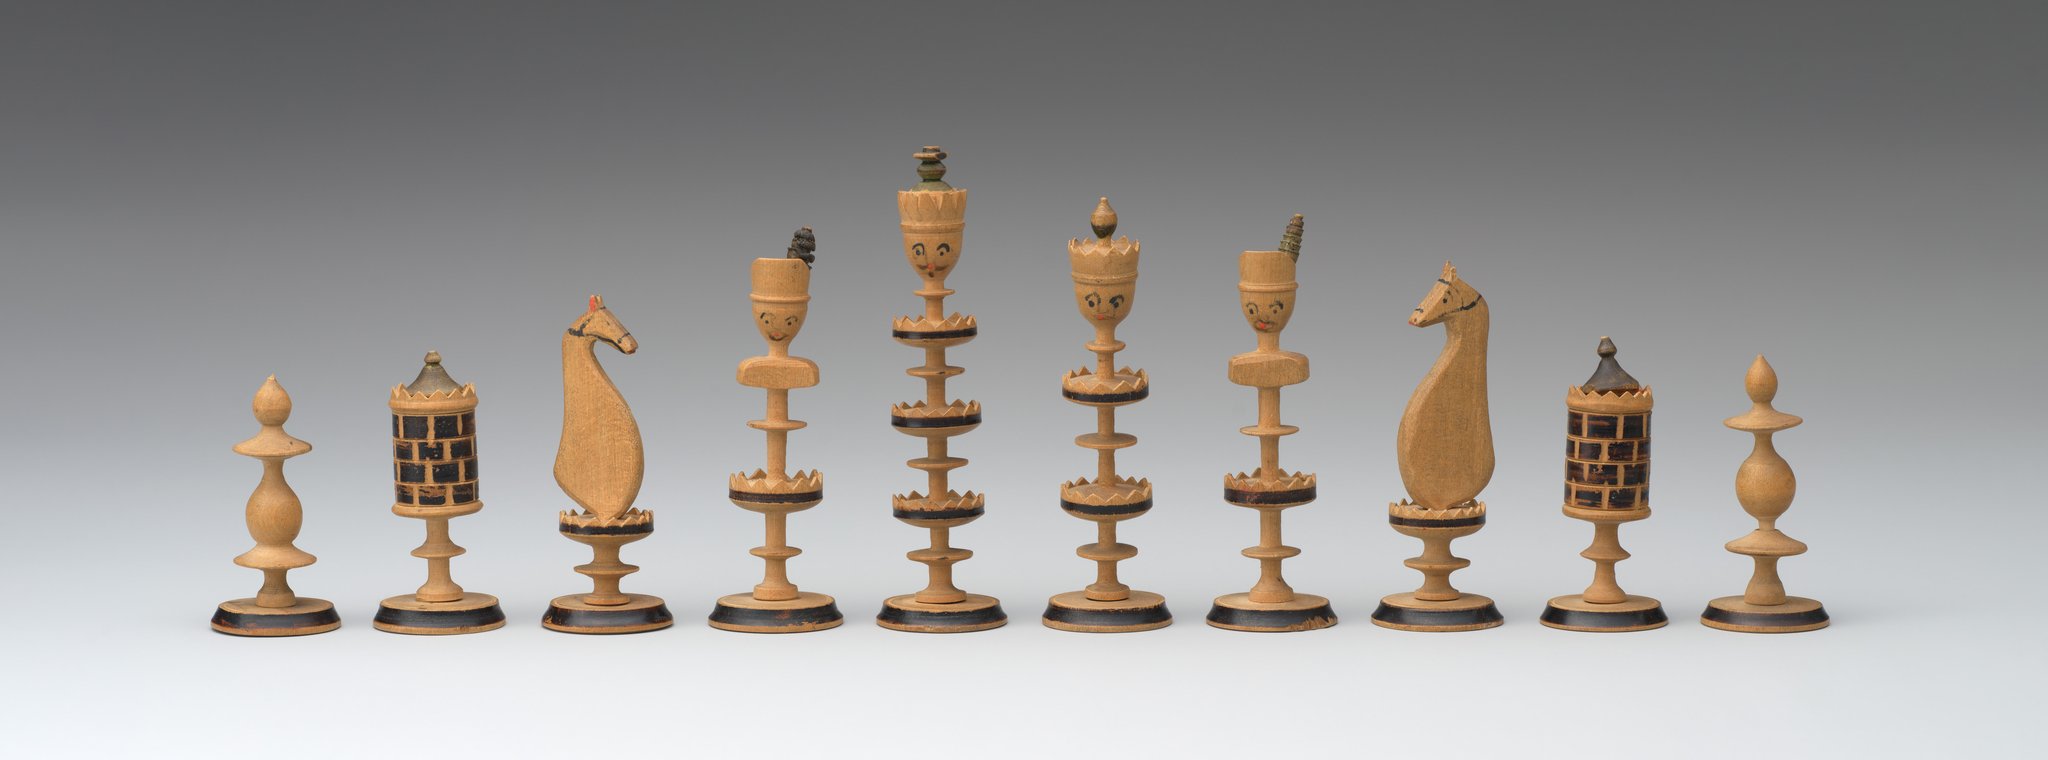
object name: chessman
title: Chessmen (32)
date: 1801-1900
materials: wood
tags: chess